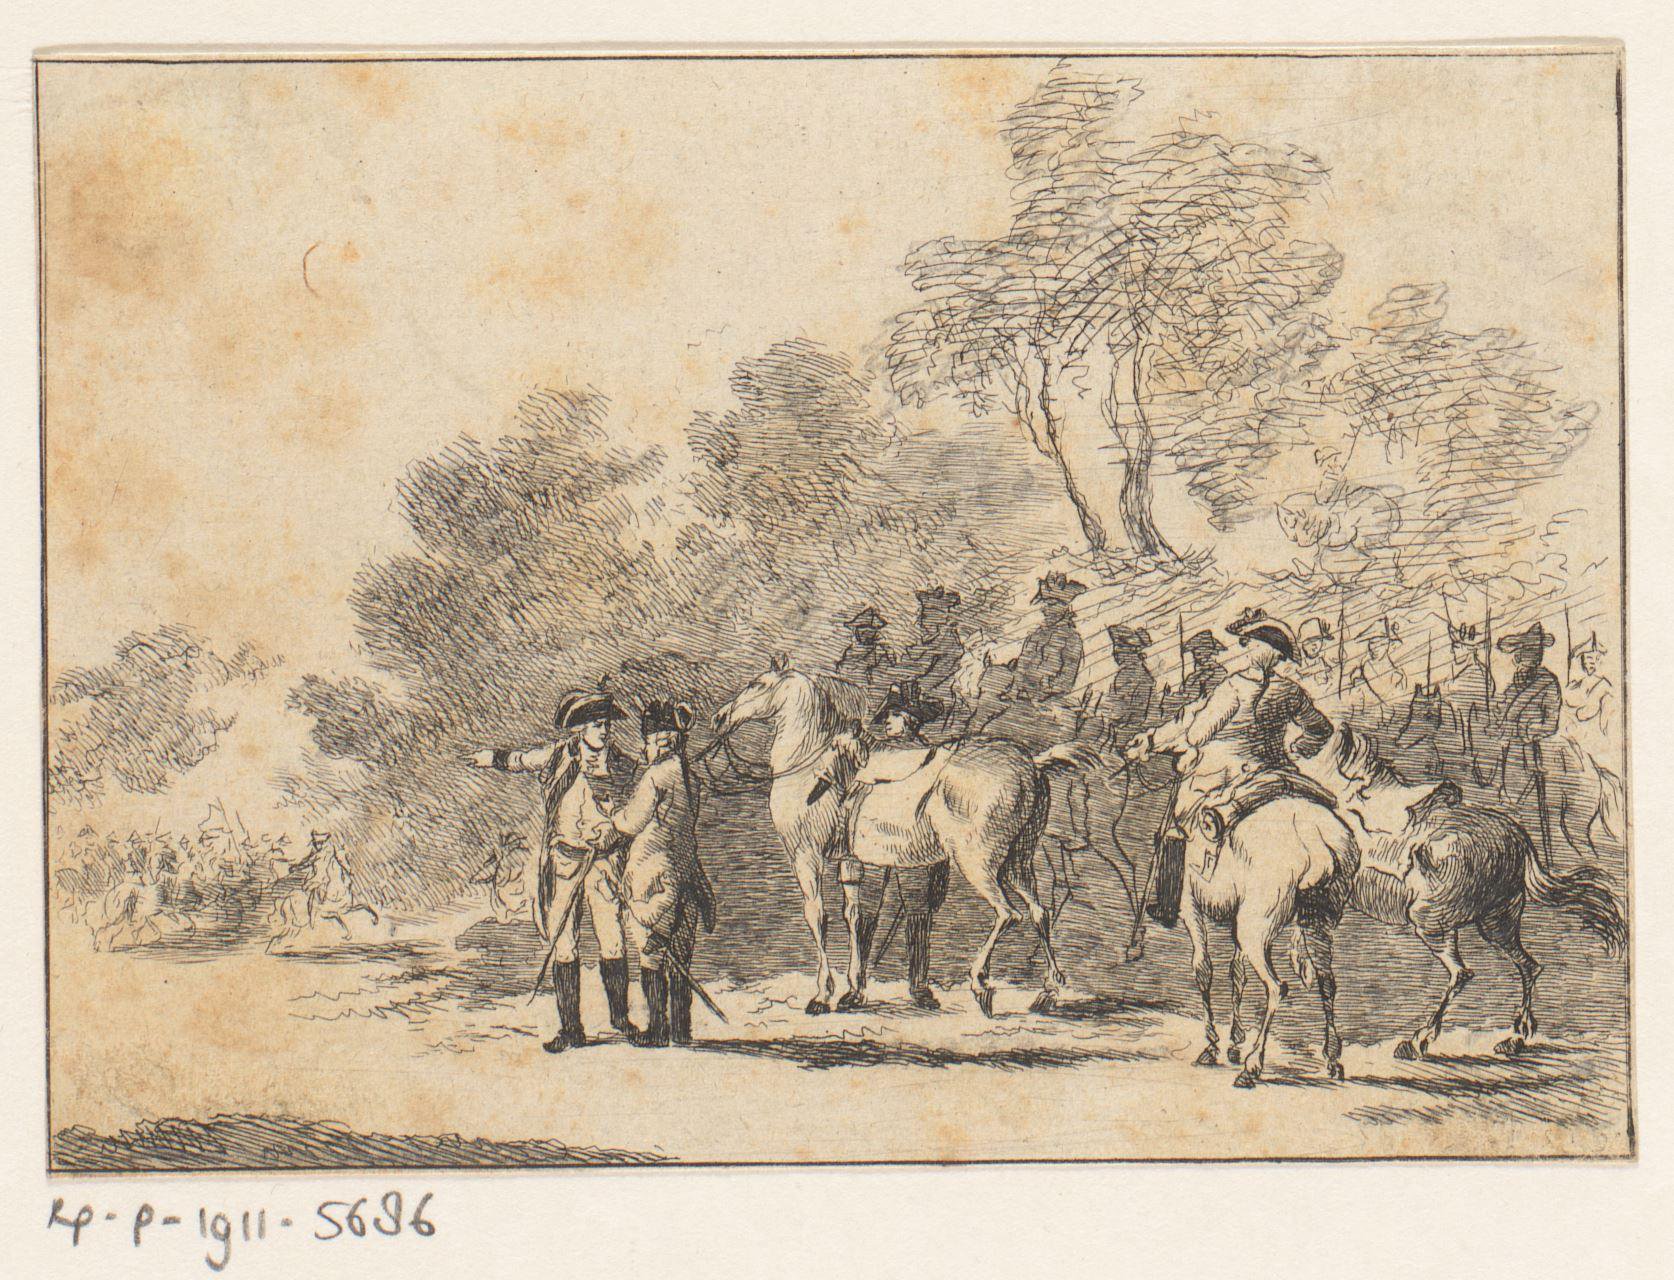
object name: print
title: Cavalerie nabij een veldslag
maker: dirk langendijk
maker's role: draughtsman, painter, print maker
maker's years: 1748-1805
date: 1758-1805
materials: paper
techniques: etching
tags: battle, fighting in general, military discipline (+ cavalry, horsemen)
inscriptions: collector's mark: Lugt 2228, collector's mark: Lugt 1485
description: Een groep ruiters staat, in afwachting van het overleg dat twee bevelhebbers met elkaar voeren, klaar om deel te nemen aan de veldslag die in de verte reeds gevoerd wordt.